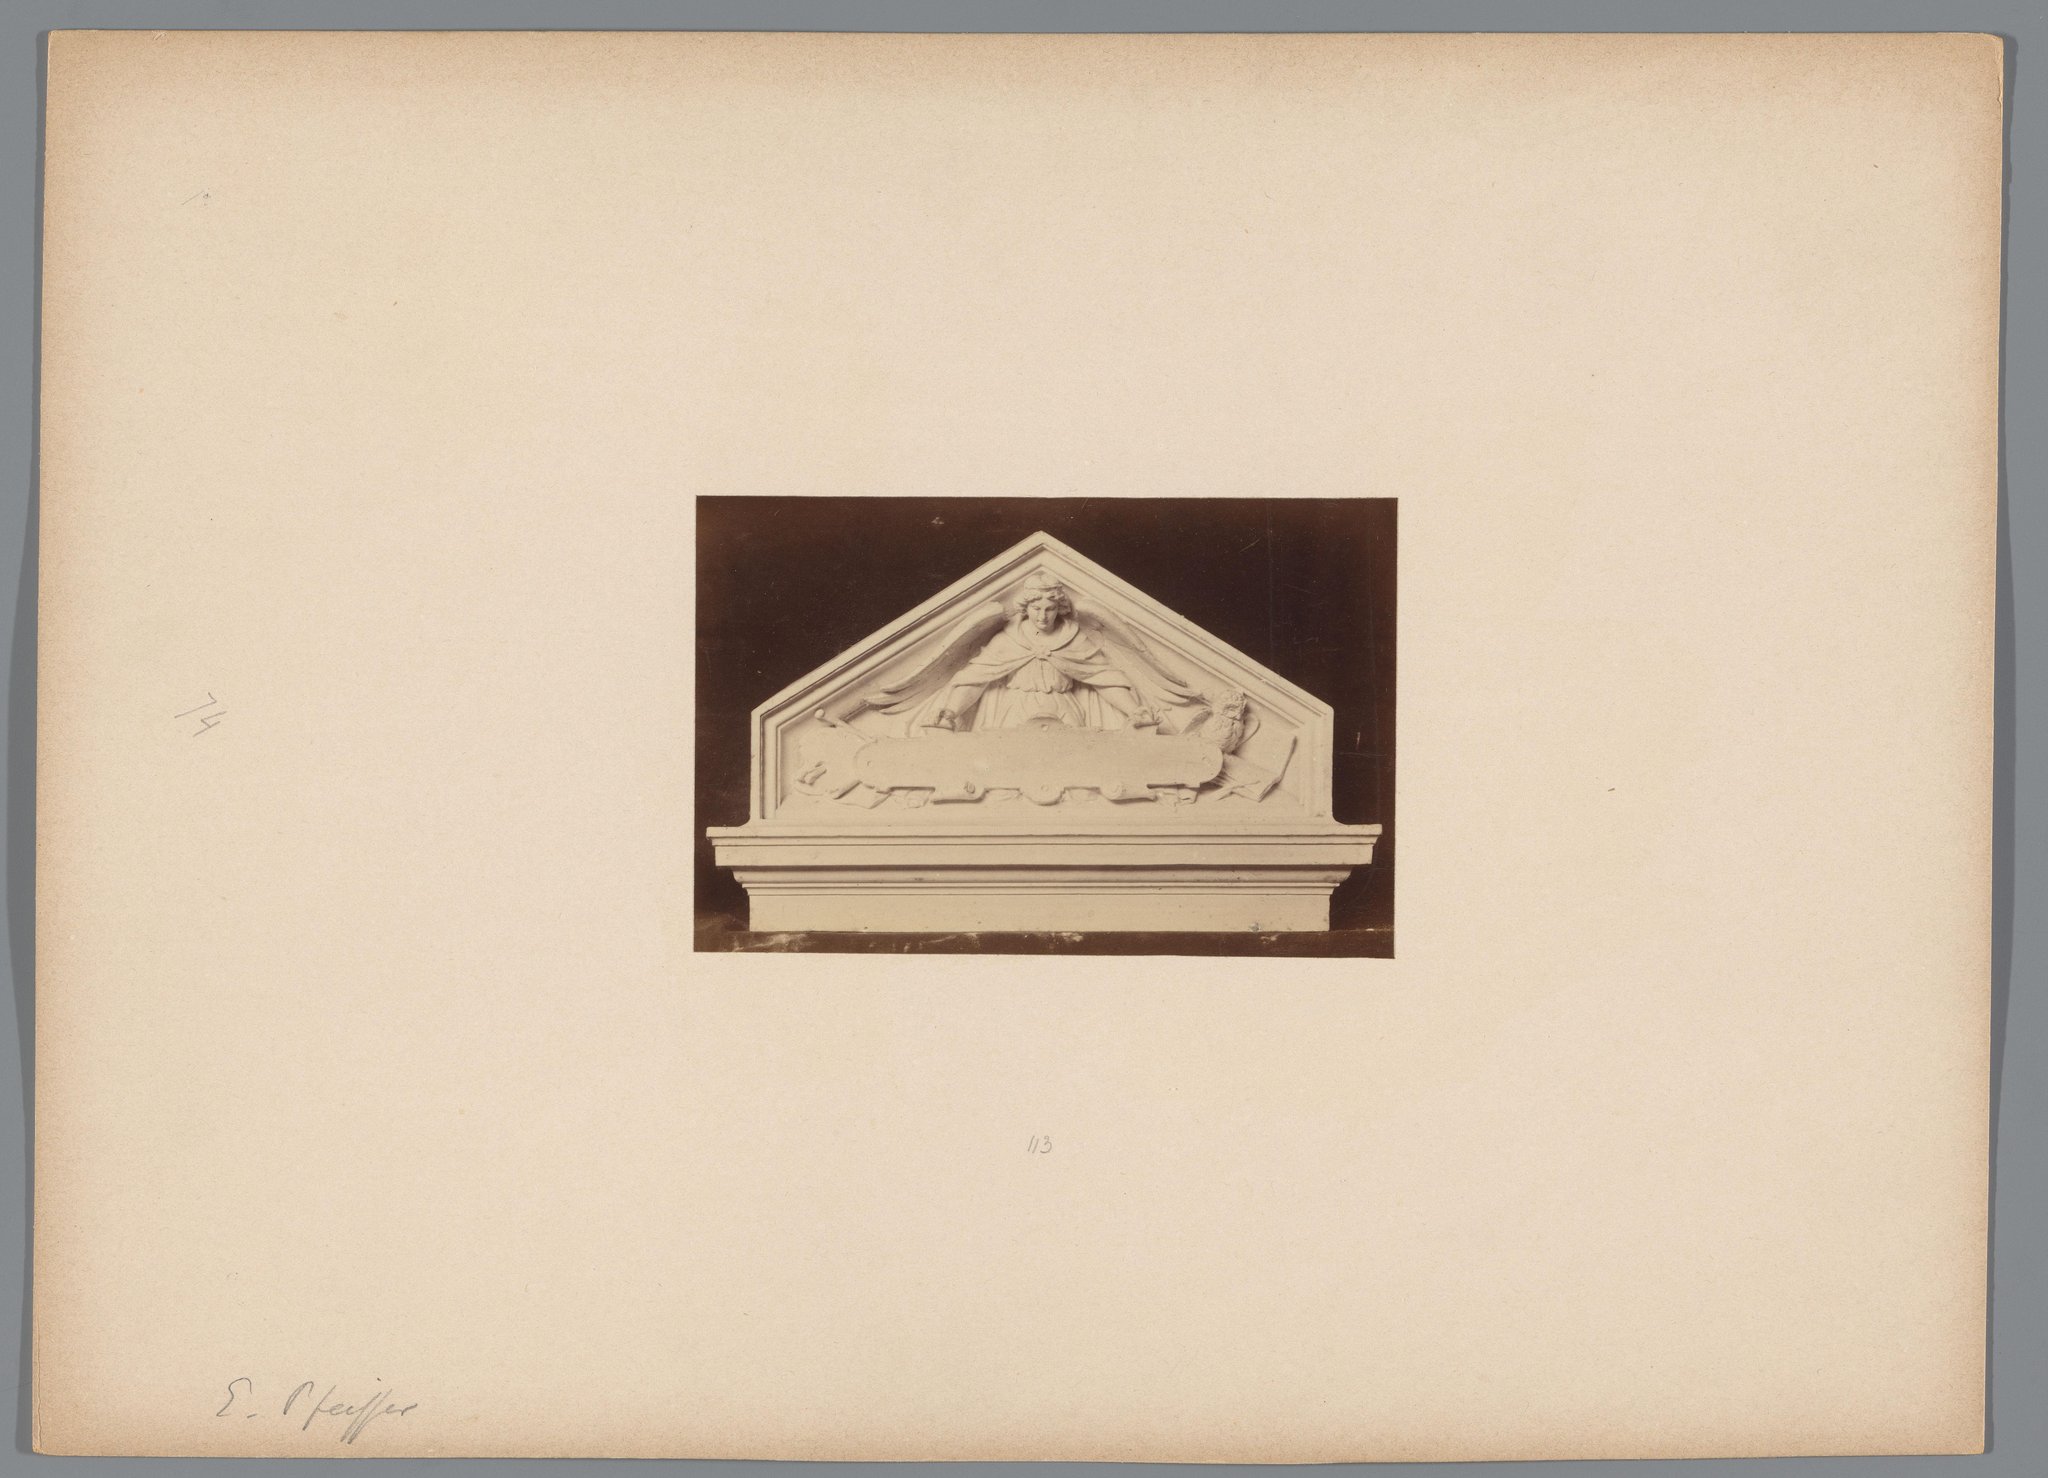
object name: reproduction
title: Modellen van beeldhouwwerken voor een prijsvraag uitgeschreven door het Rijksmuseum Amsterdam, 1880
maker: Anonymous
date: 1880-1887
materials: cardboard, paper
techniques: albumen print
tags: piece of sculpture, reproduction of a piece of sculpture, angels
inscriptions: collector's mark: Lugt 2228, inscription: ‘113/ 74’, inscription: ‘E. Pfeiffer’